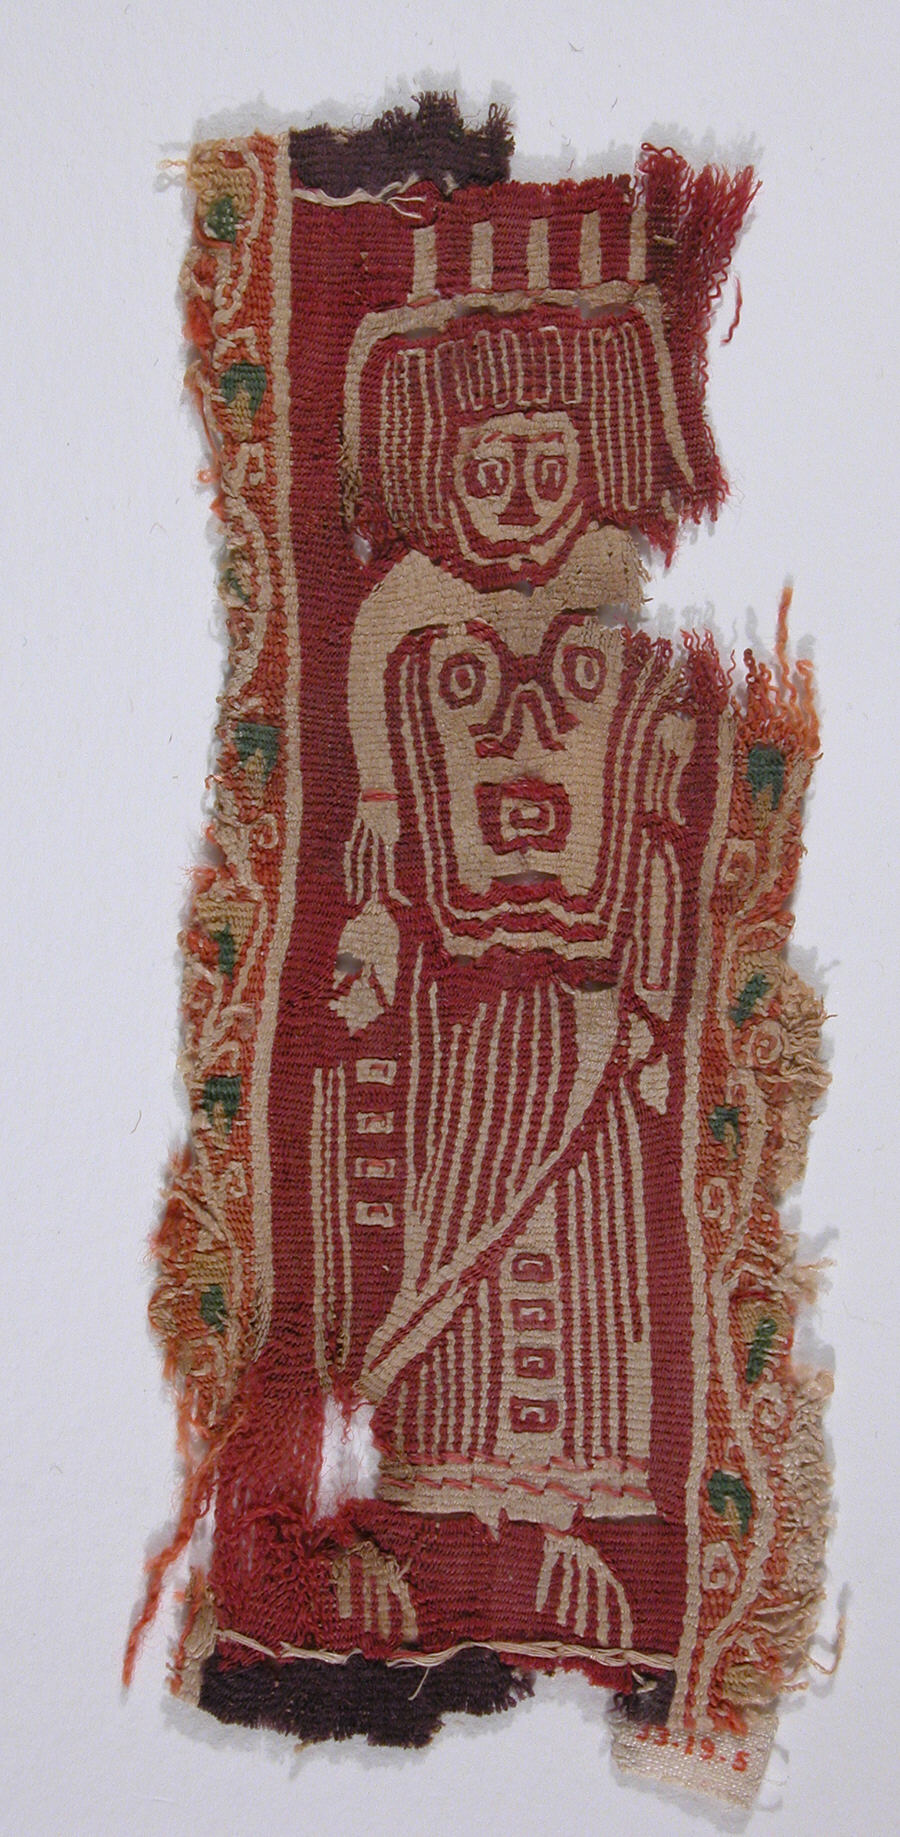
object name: textile fragment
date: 401-500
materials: linen, wool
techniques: weave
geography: egypt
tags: human figures